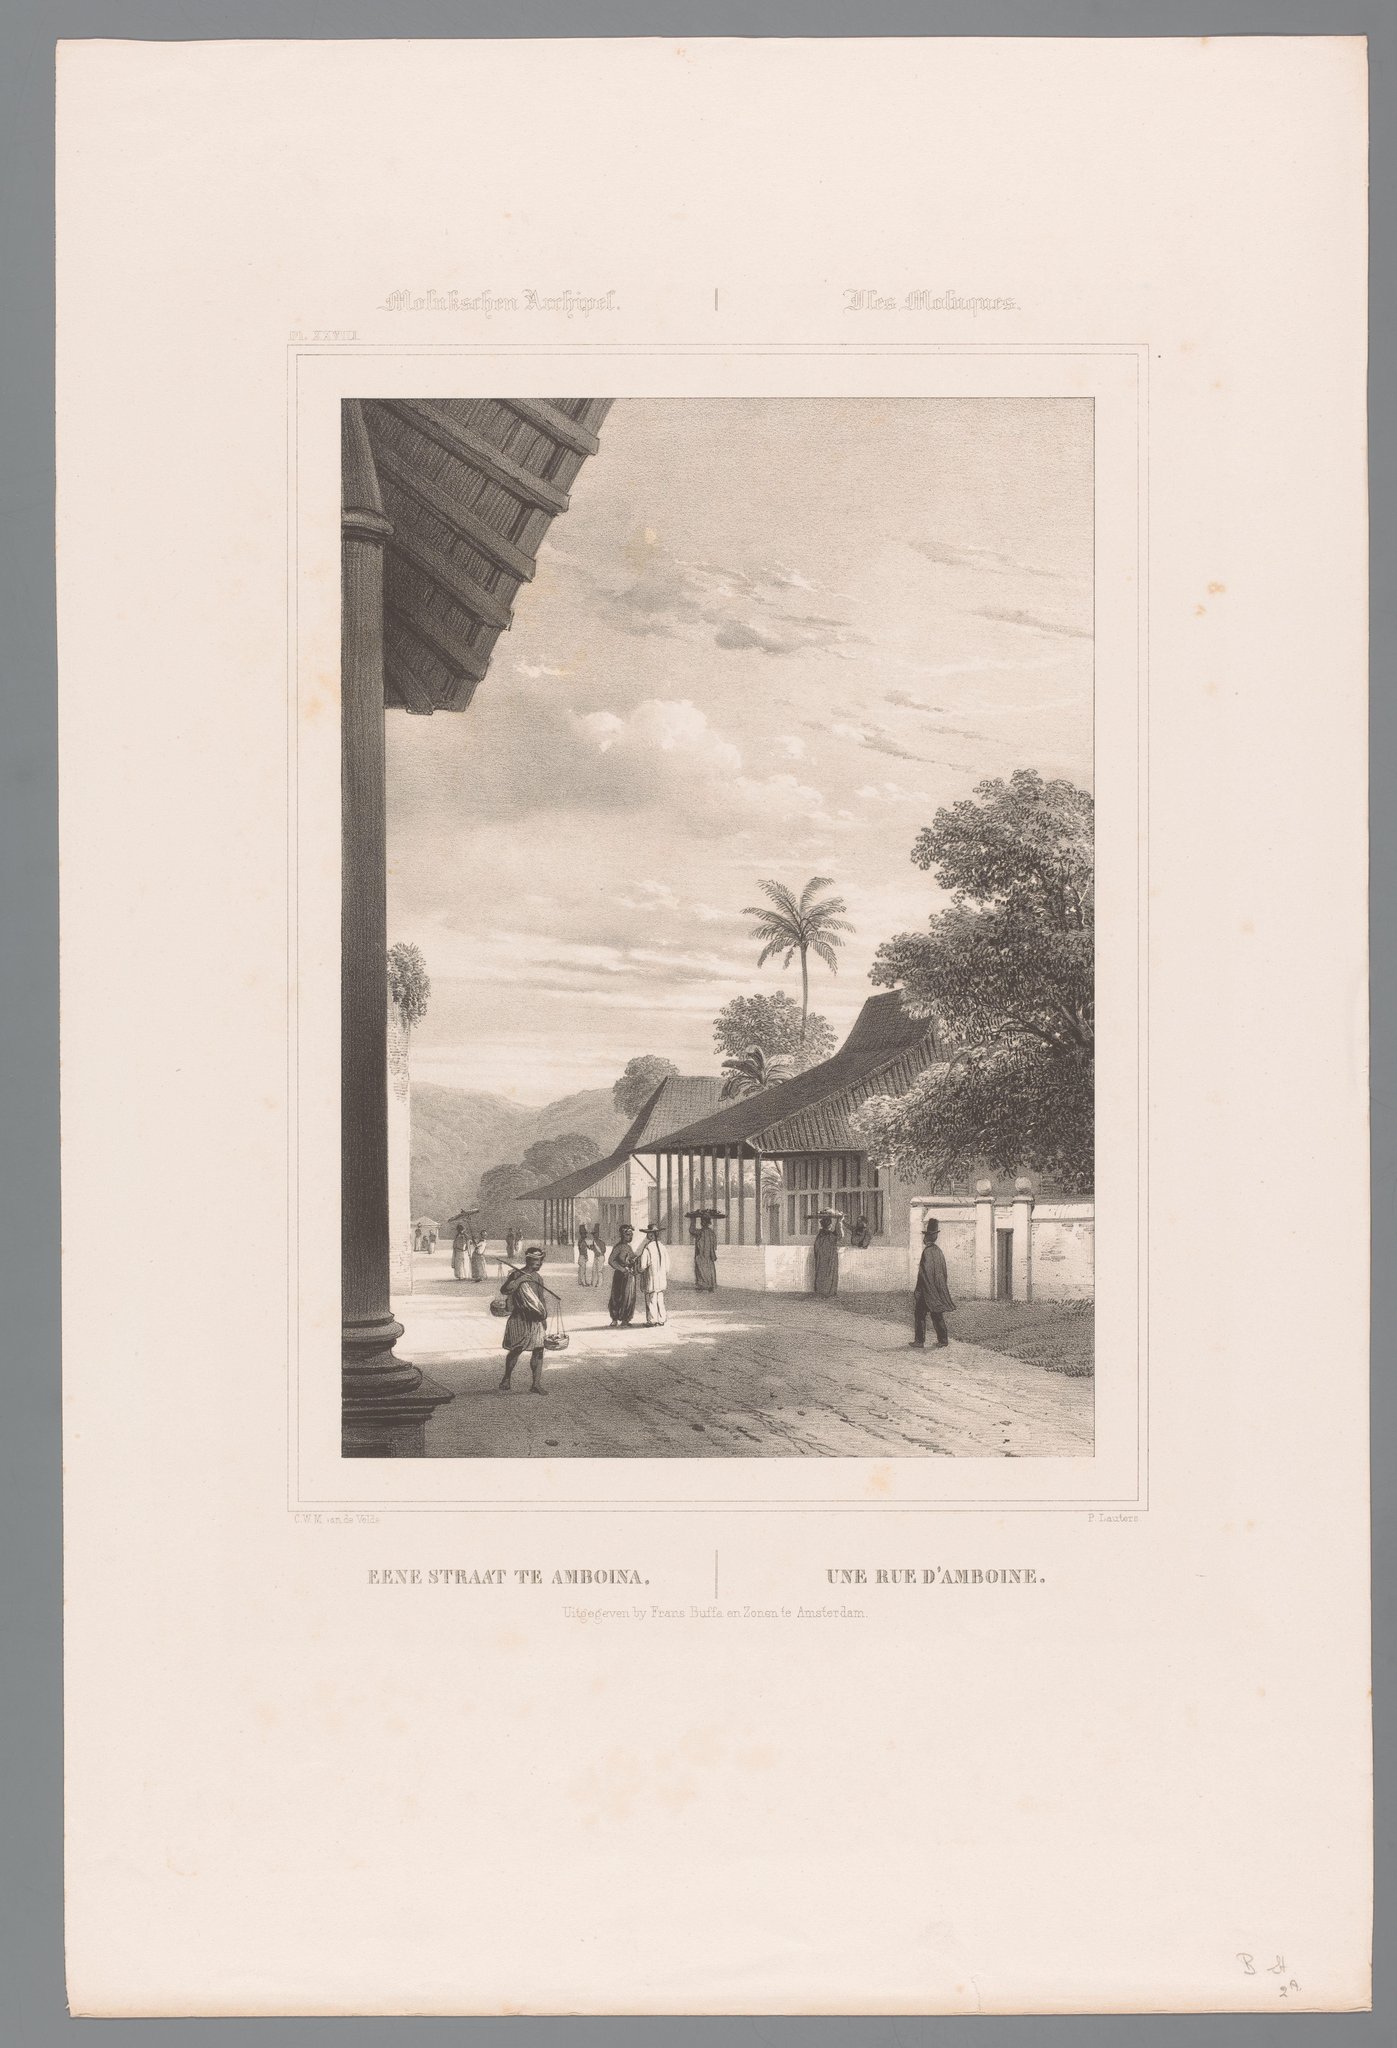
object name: print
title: Gezicht op een straat in Ambon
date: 1847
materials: paper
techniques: lithograph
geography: amsterdam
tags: street (+ city(-scape) with figures, staffage)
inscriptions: collector's mark: Lugt 2228